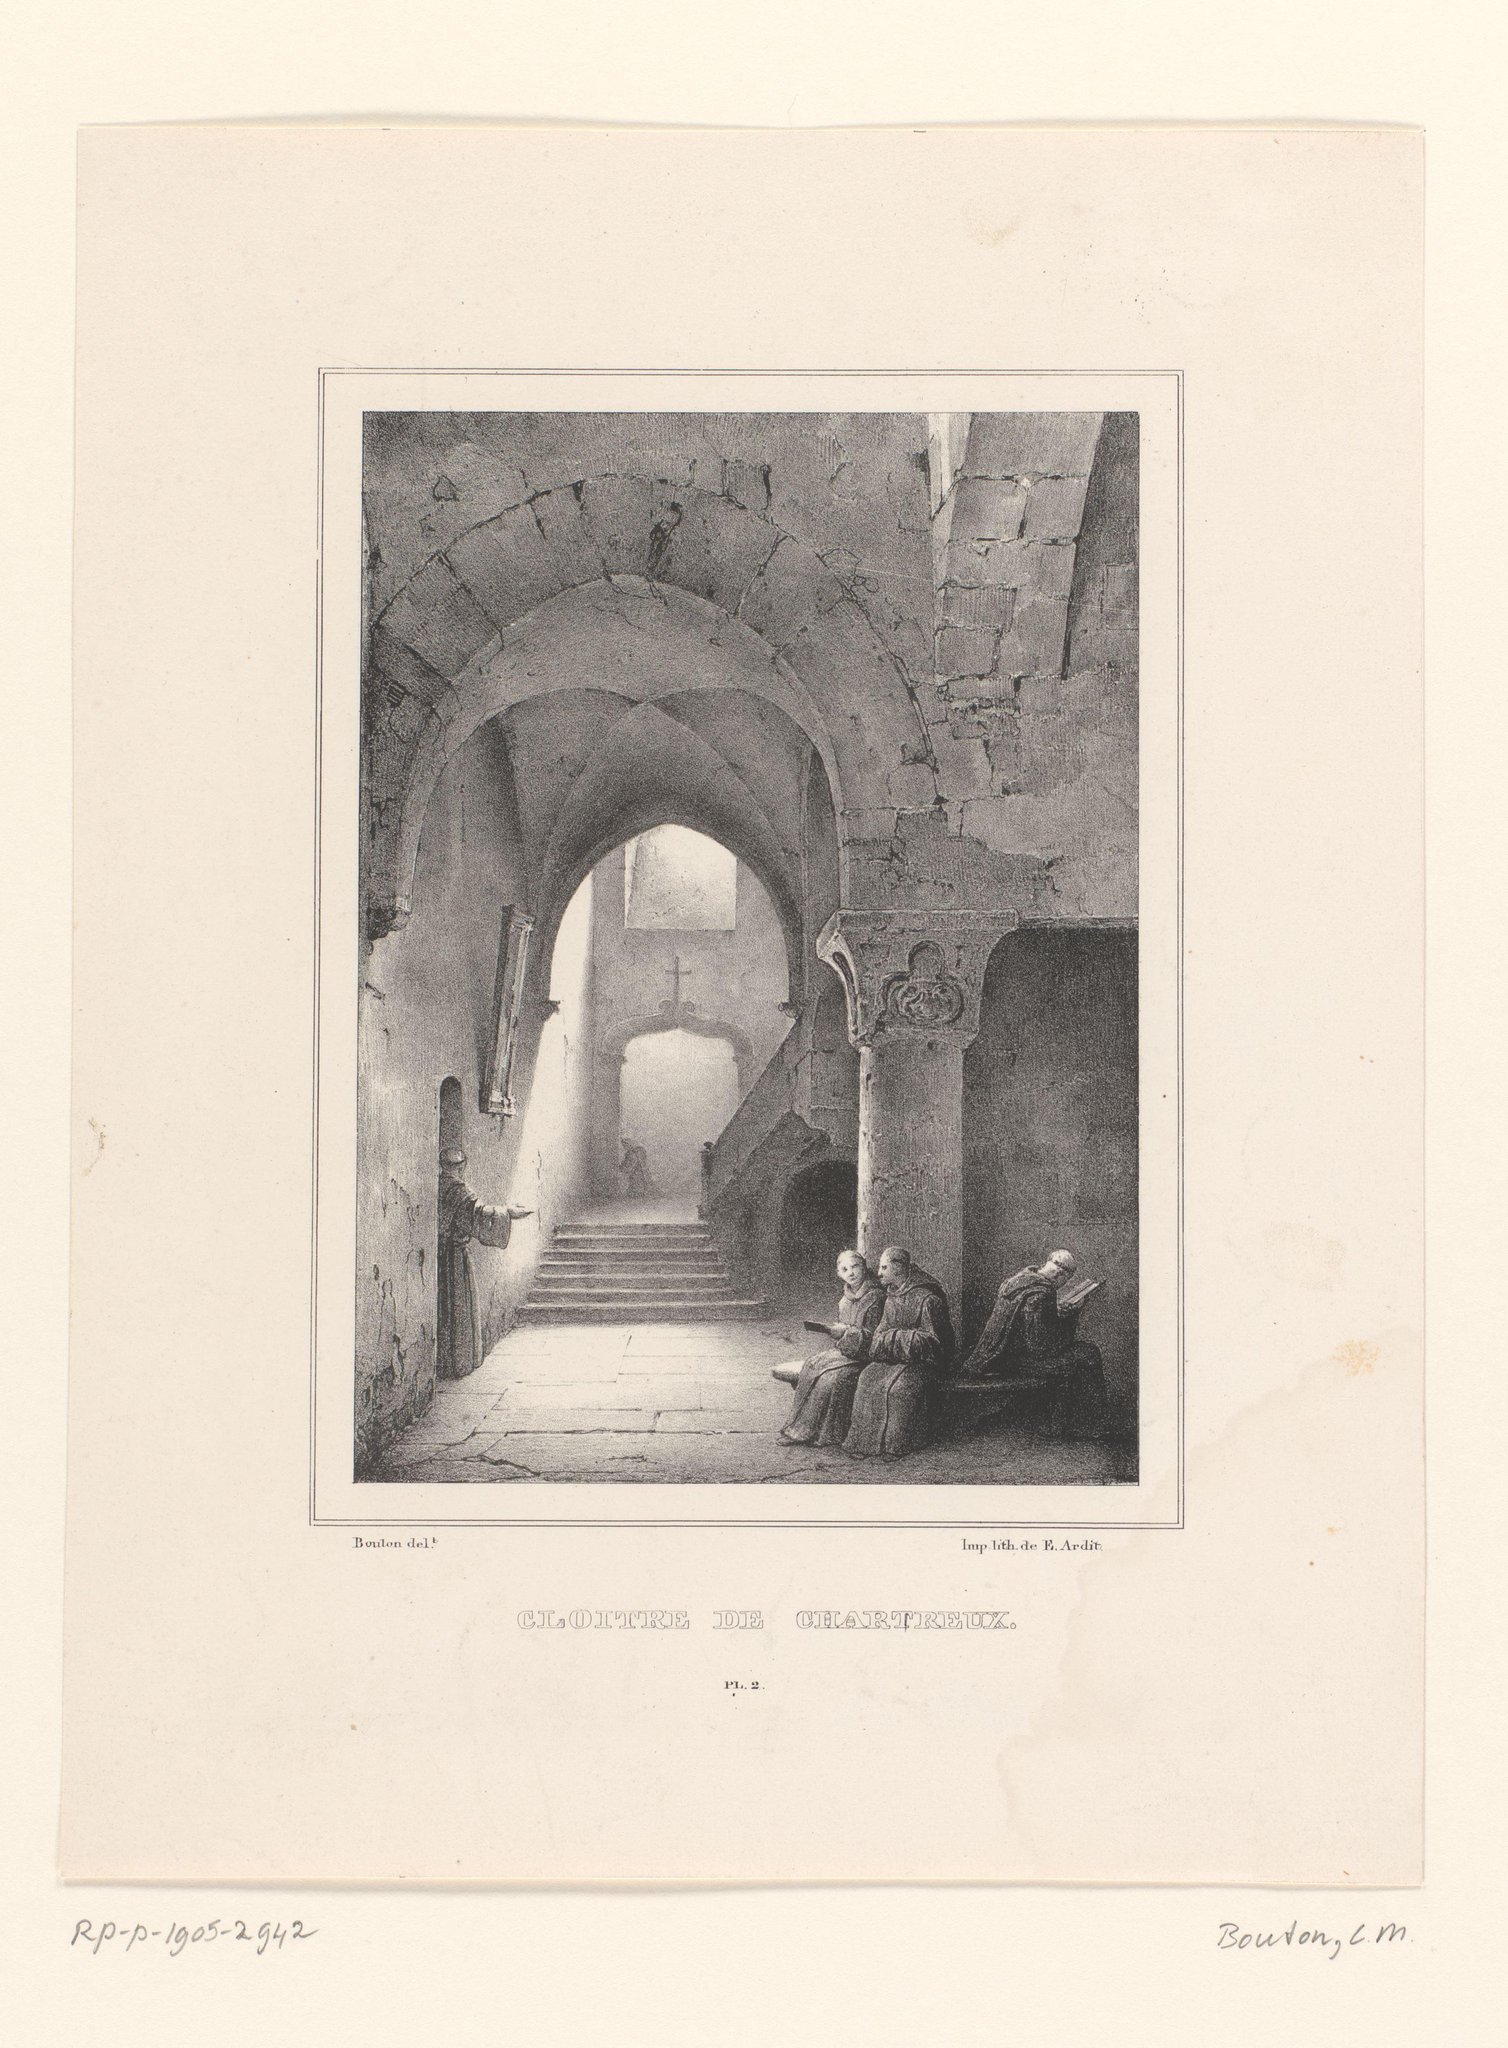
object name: print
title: Six Intérieurs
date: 1832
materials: paper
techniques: lithograph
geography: paris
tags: monastic orders, monastic life: carthusians, cloisters ~ monastery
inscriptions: collector's mark: Lugt 2228a